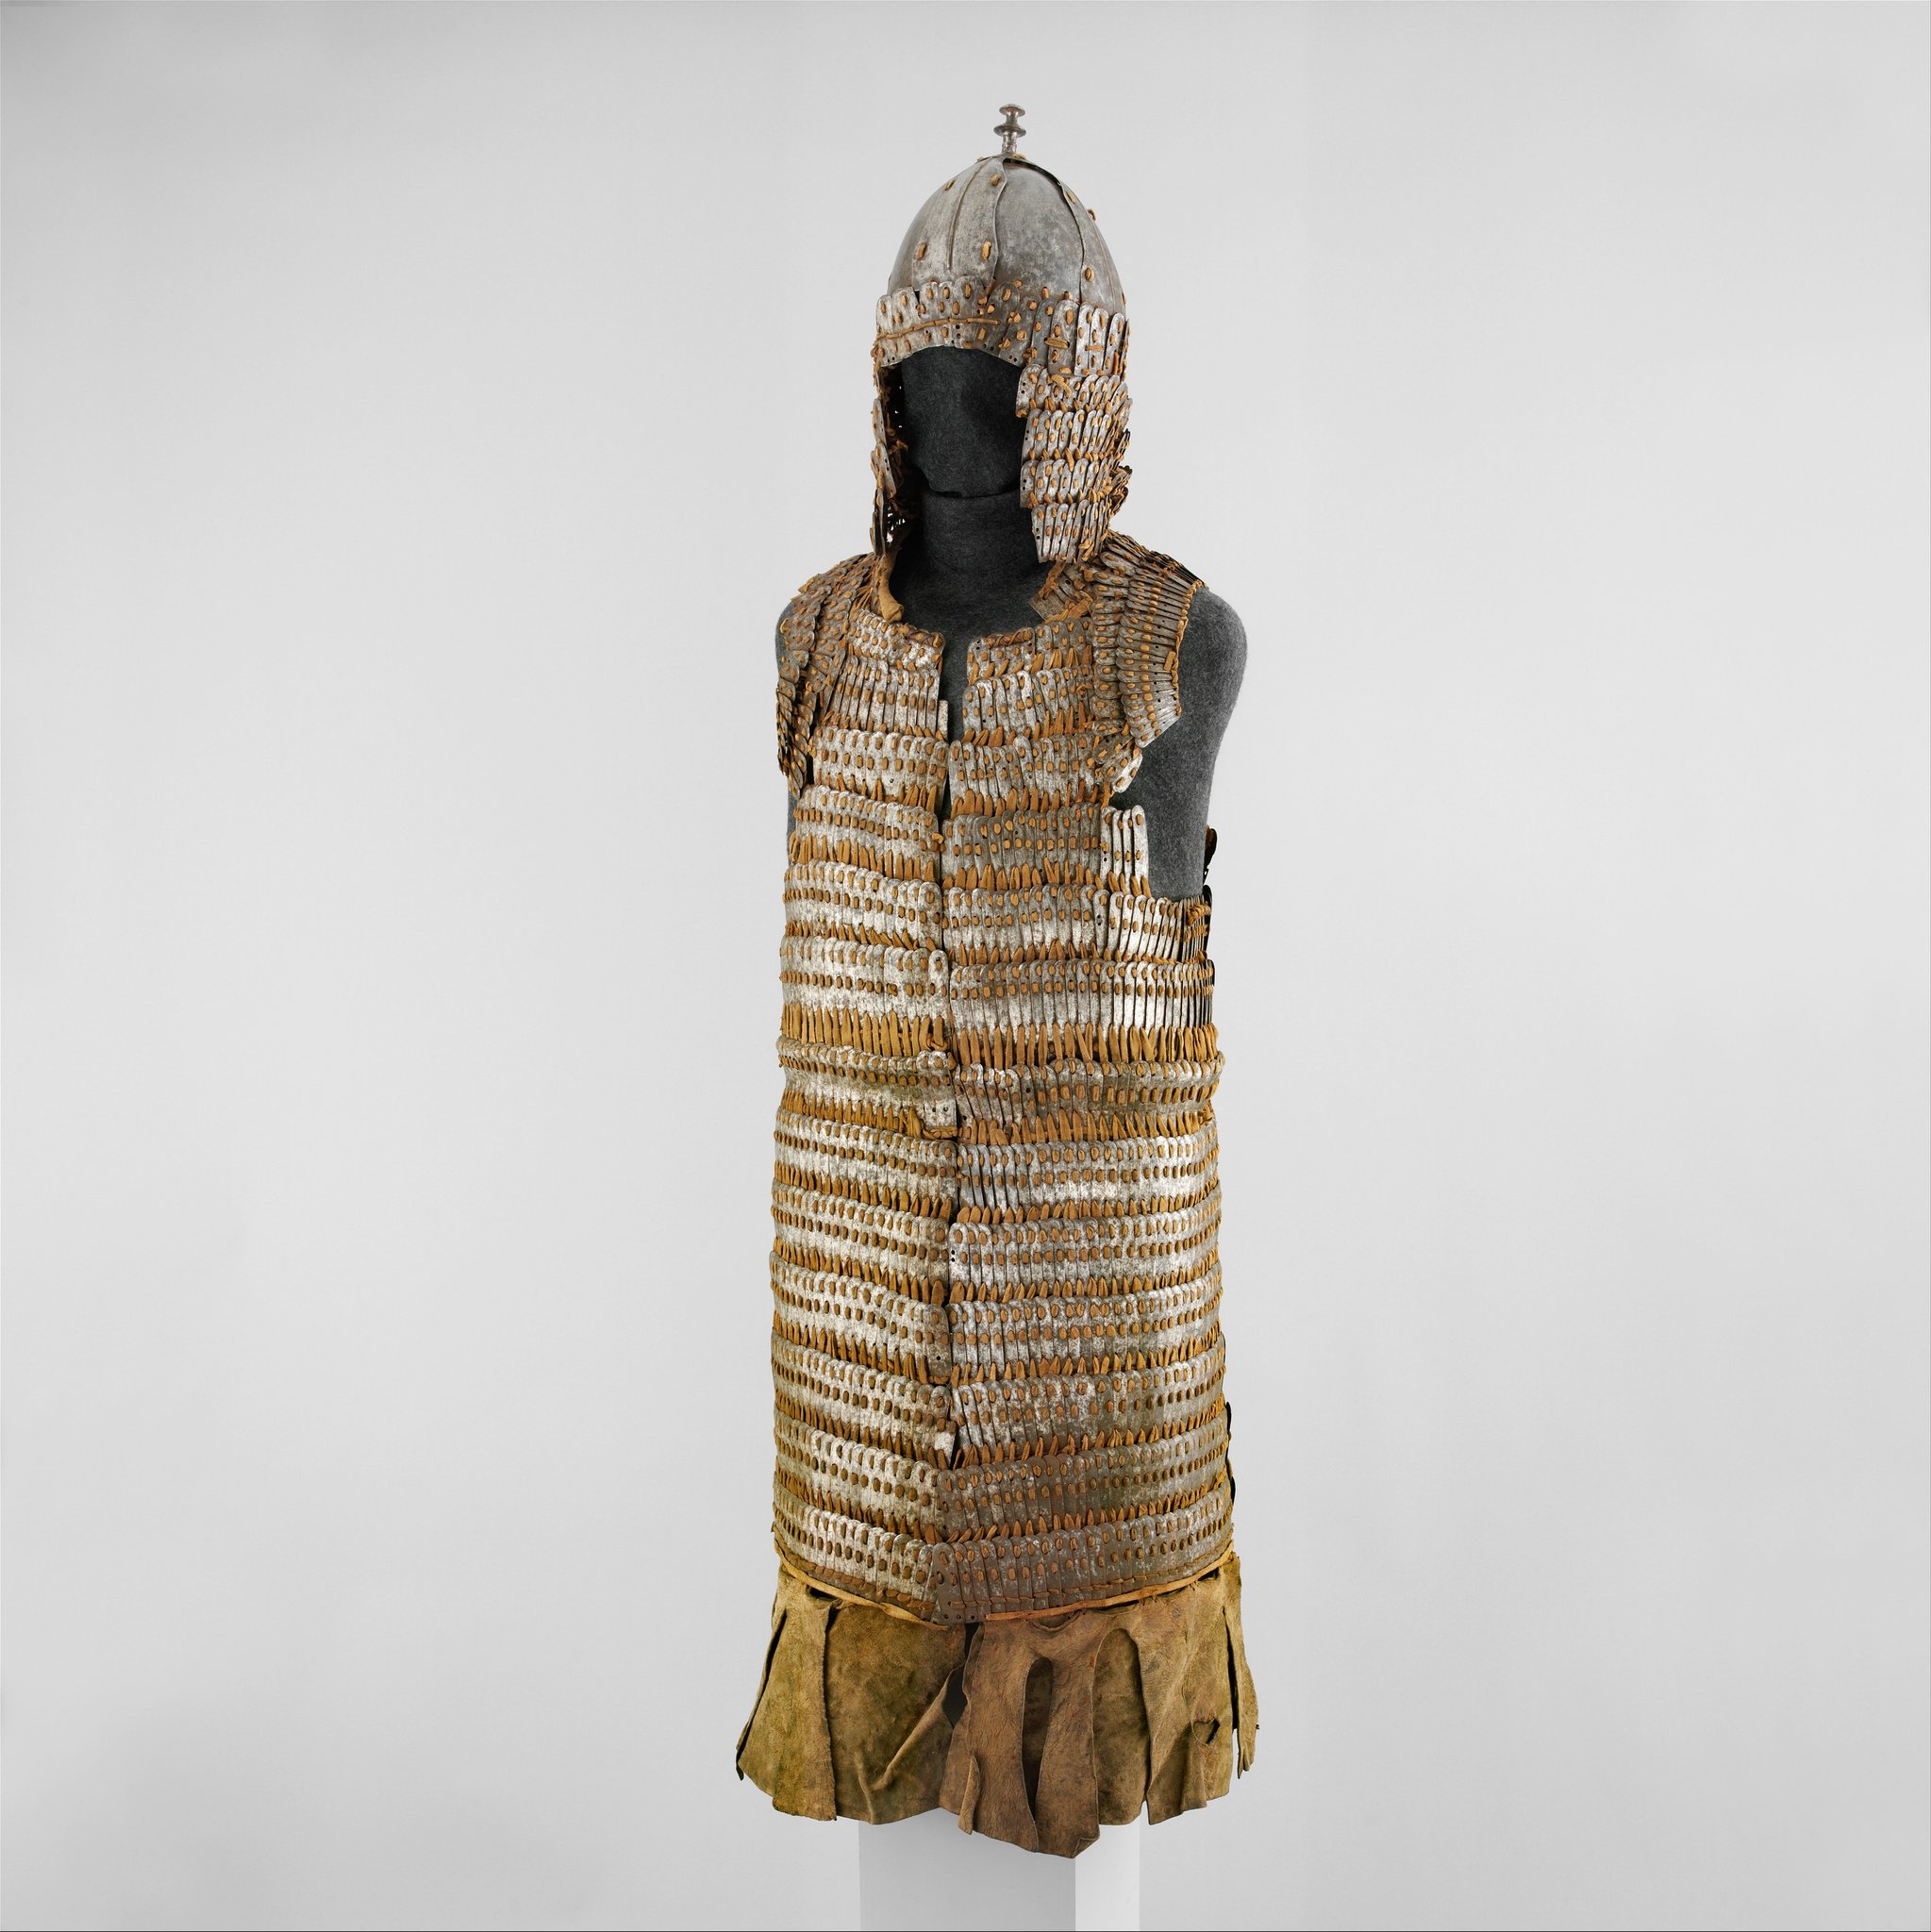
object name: lamellar armor byang bu'i khrab and helmet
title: Lamellar Armor (Byang Bu'i Khrab) and Helmet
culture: tibetan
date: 1501-1700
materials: iron, leather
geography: tibet